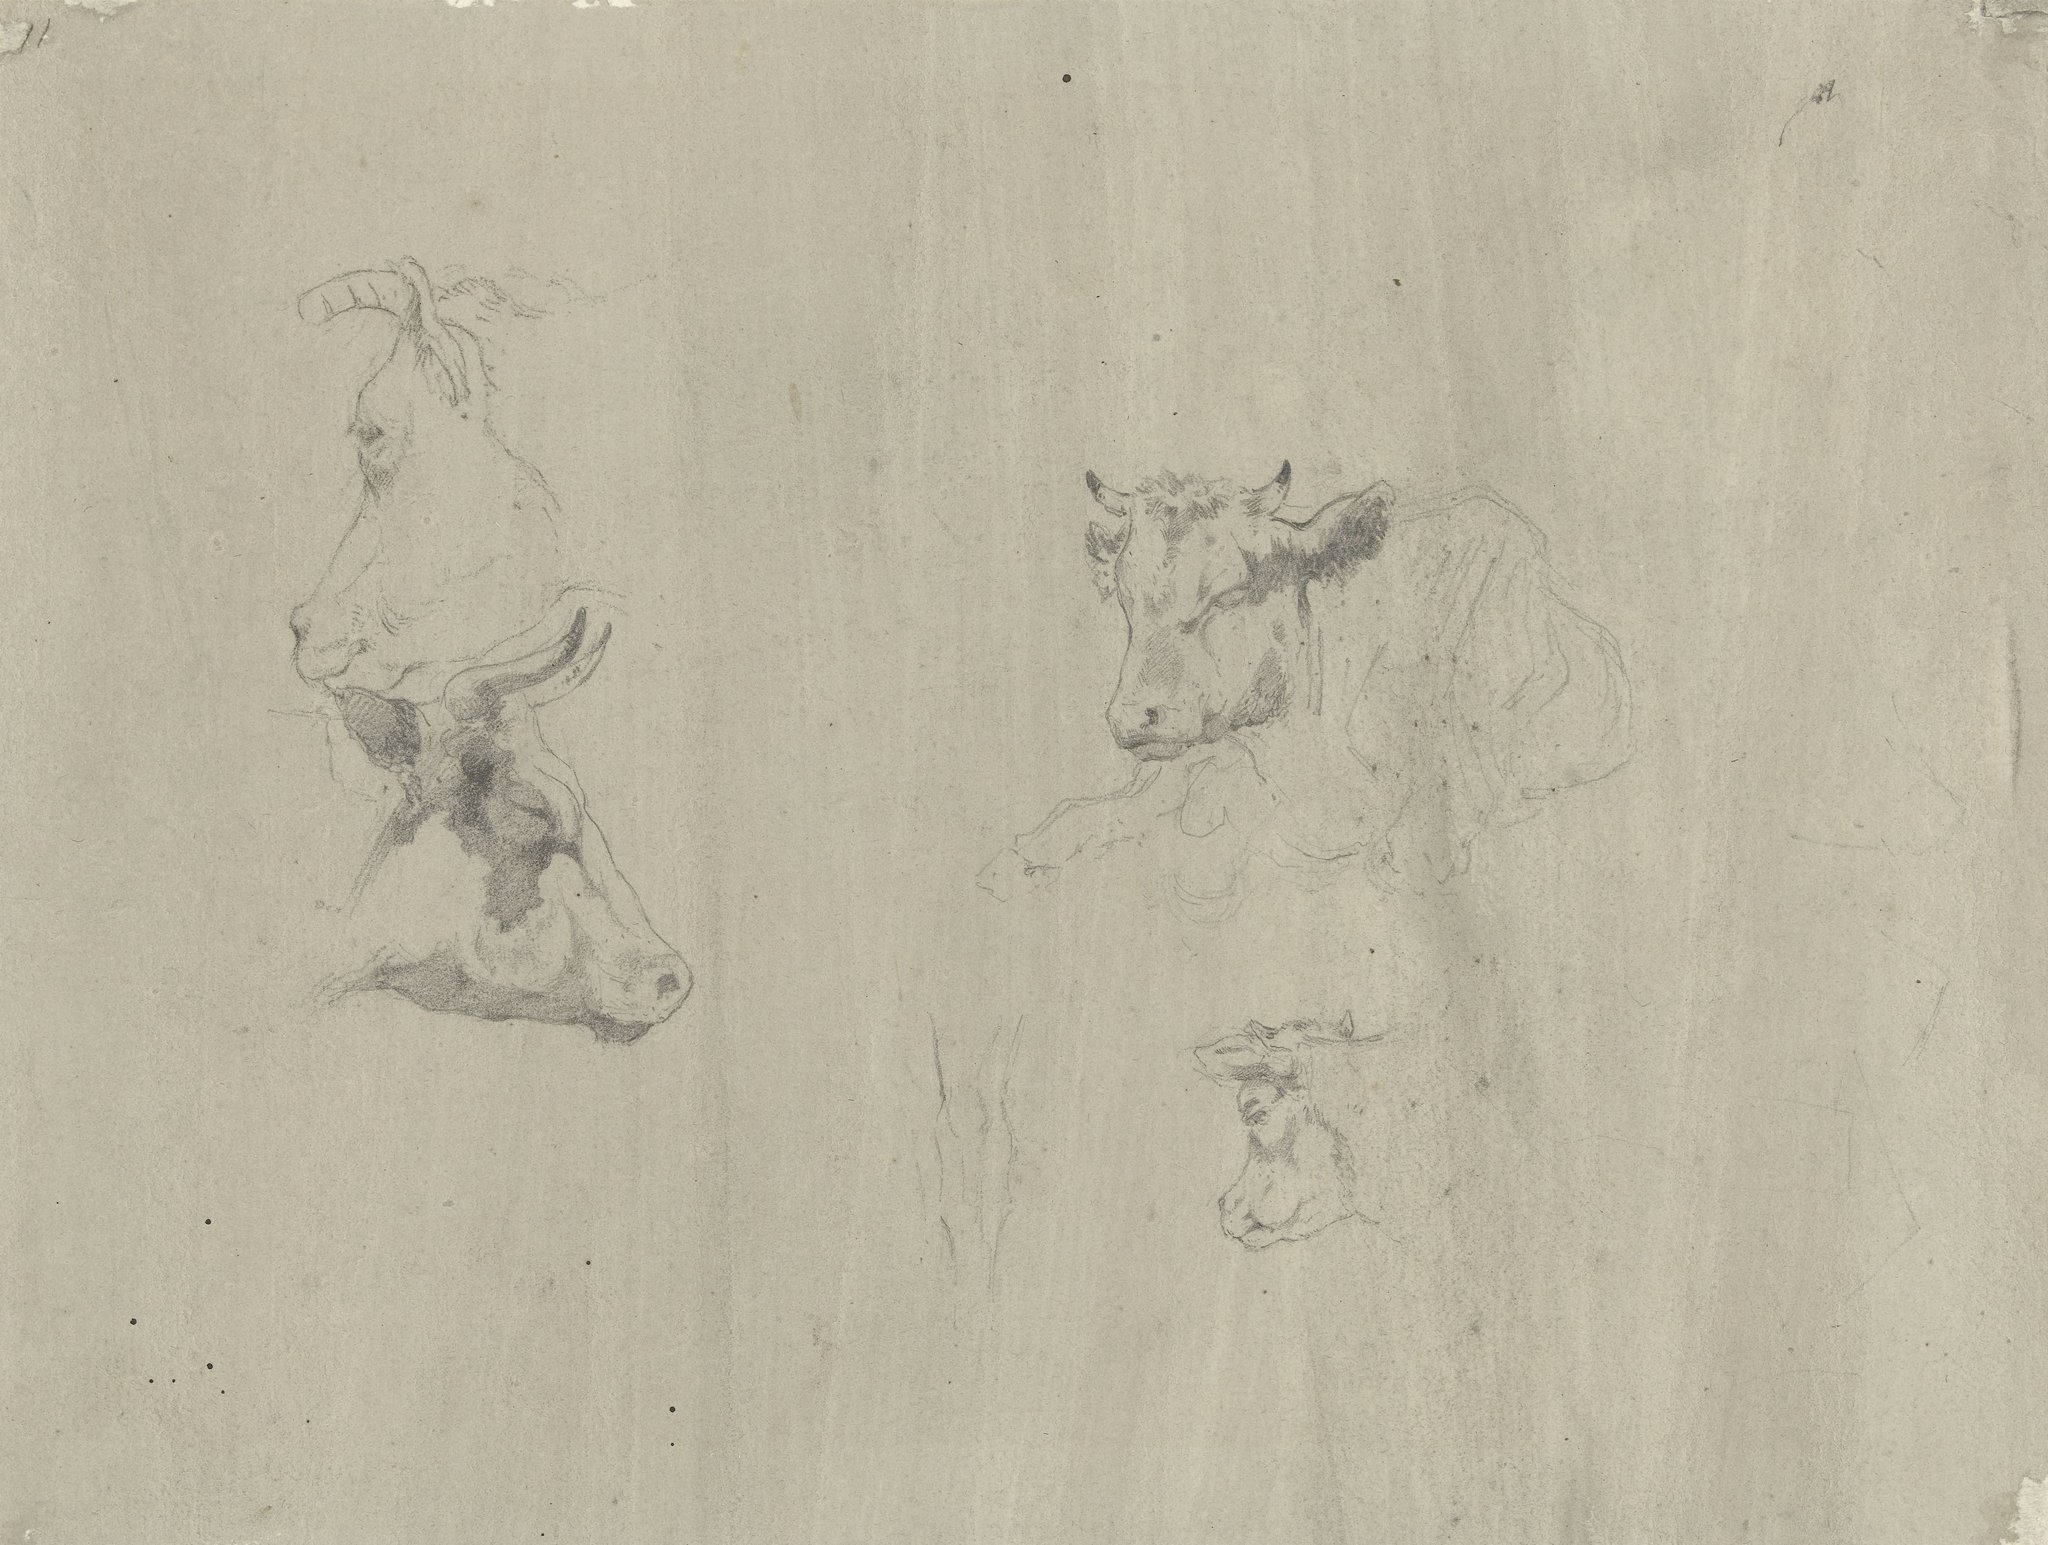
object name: drawing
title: Studies van koeien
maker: gerard bilders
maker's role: draughtsman, print maker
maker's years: 1838-1865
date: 1848-1865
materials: pencil, paper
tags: cow